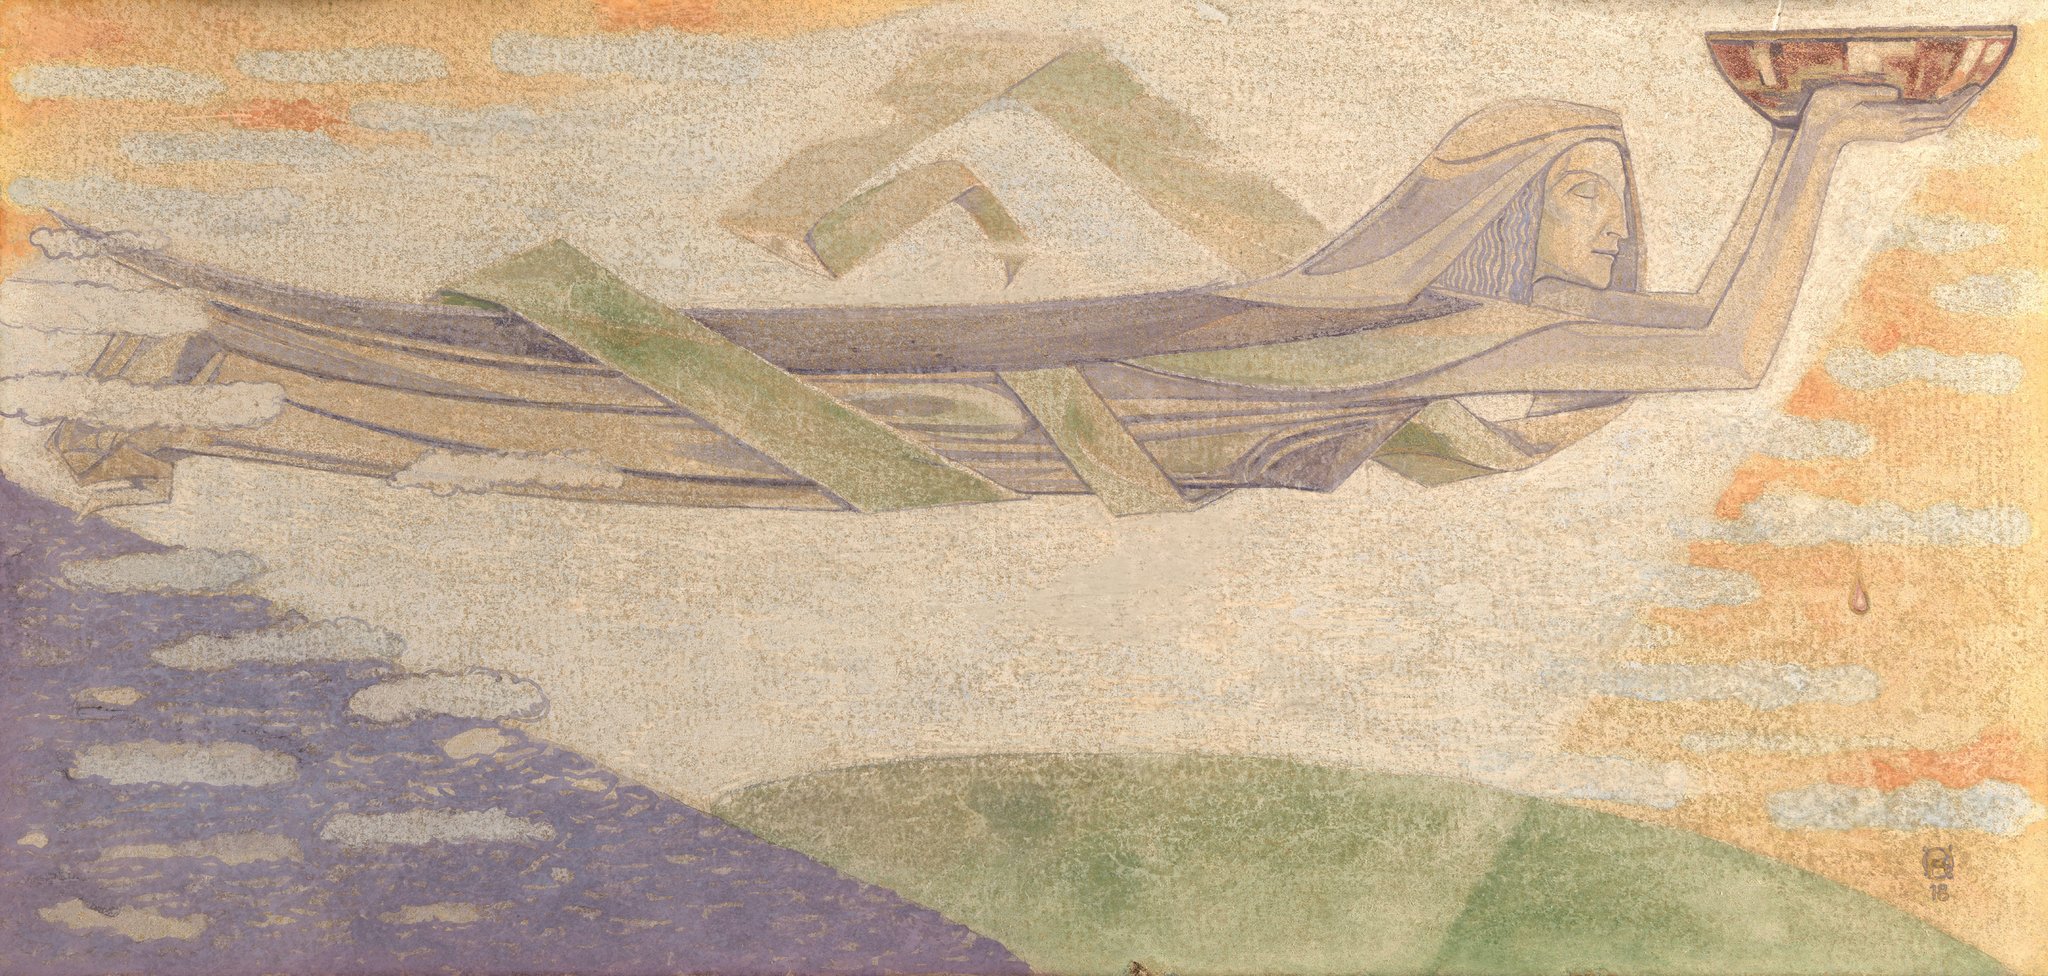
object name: painting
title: The Hours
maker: richard nicolaüs roland holst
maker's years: 1868-1938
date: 1918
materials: asbestos, asbestos cement, paint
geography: netherlands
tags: the 24 hours of day and night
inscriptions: signature and date: ‘[monogram] 18’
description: Een horizontaal naar rechts zwevende vrouwenfiguur met een kom in de naar voren gestrekte handen.